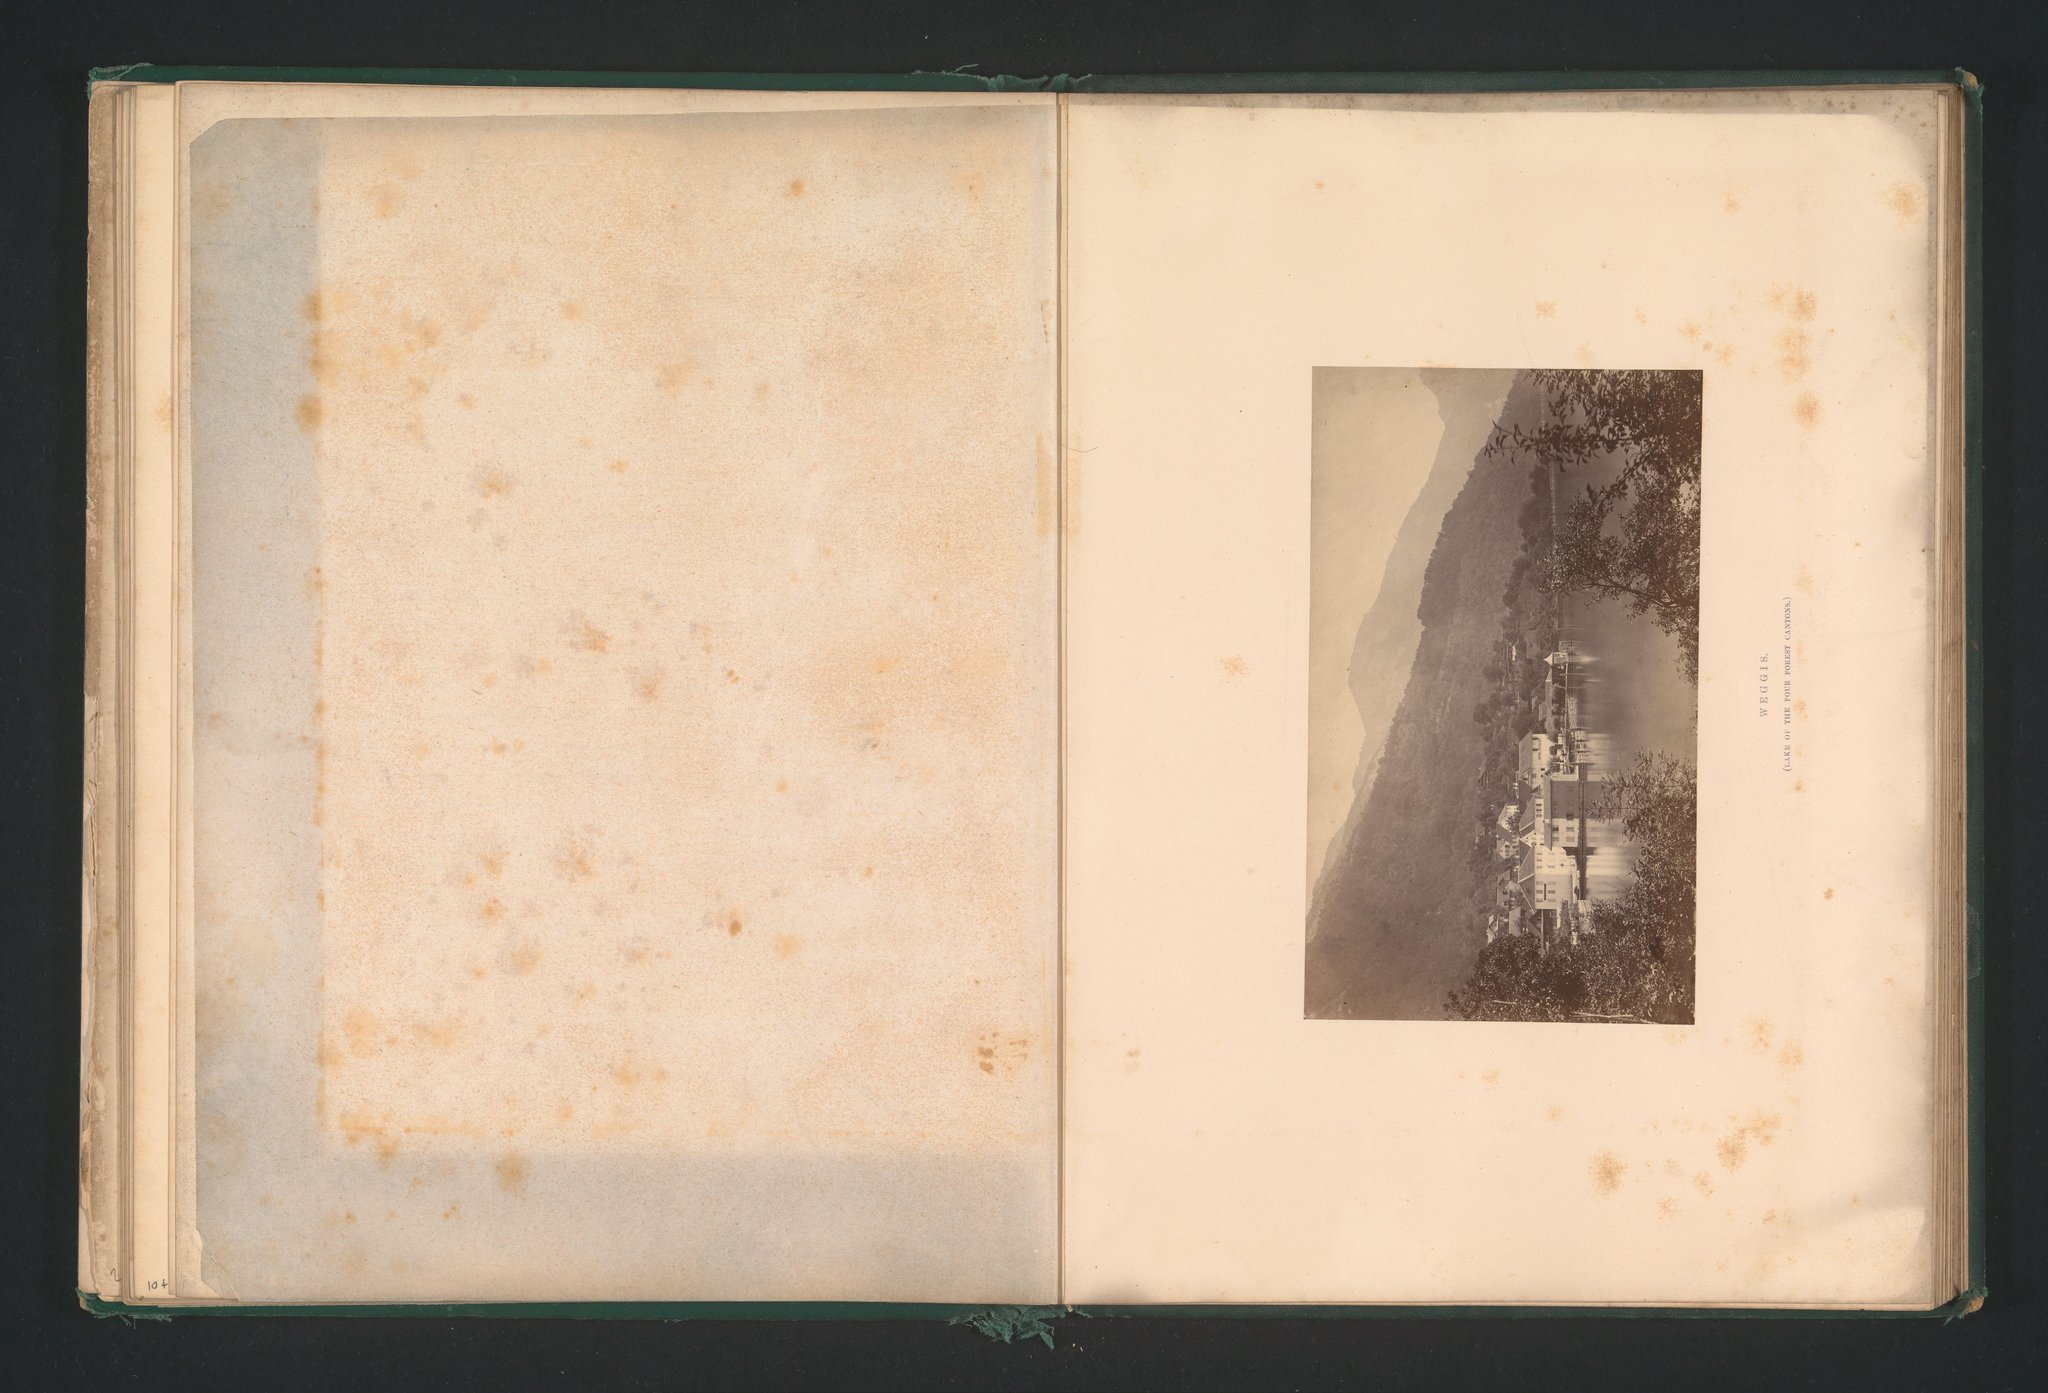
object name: page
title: Weggis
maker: stephen thompson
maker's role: fotograaf, schrijver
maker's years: 1831-1893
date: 1863-1868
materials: photographic support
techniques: albumen print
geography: weggis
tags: city-view in general; 'veduta', river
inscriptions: inscription: ‘(Lake of the four forest cantons)’